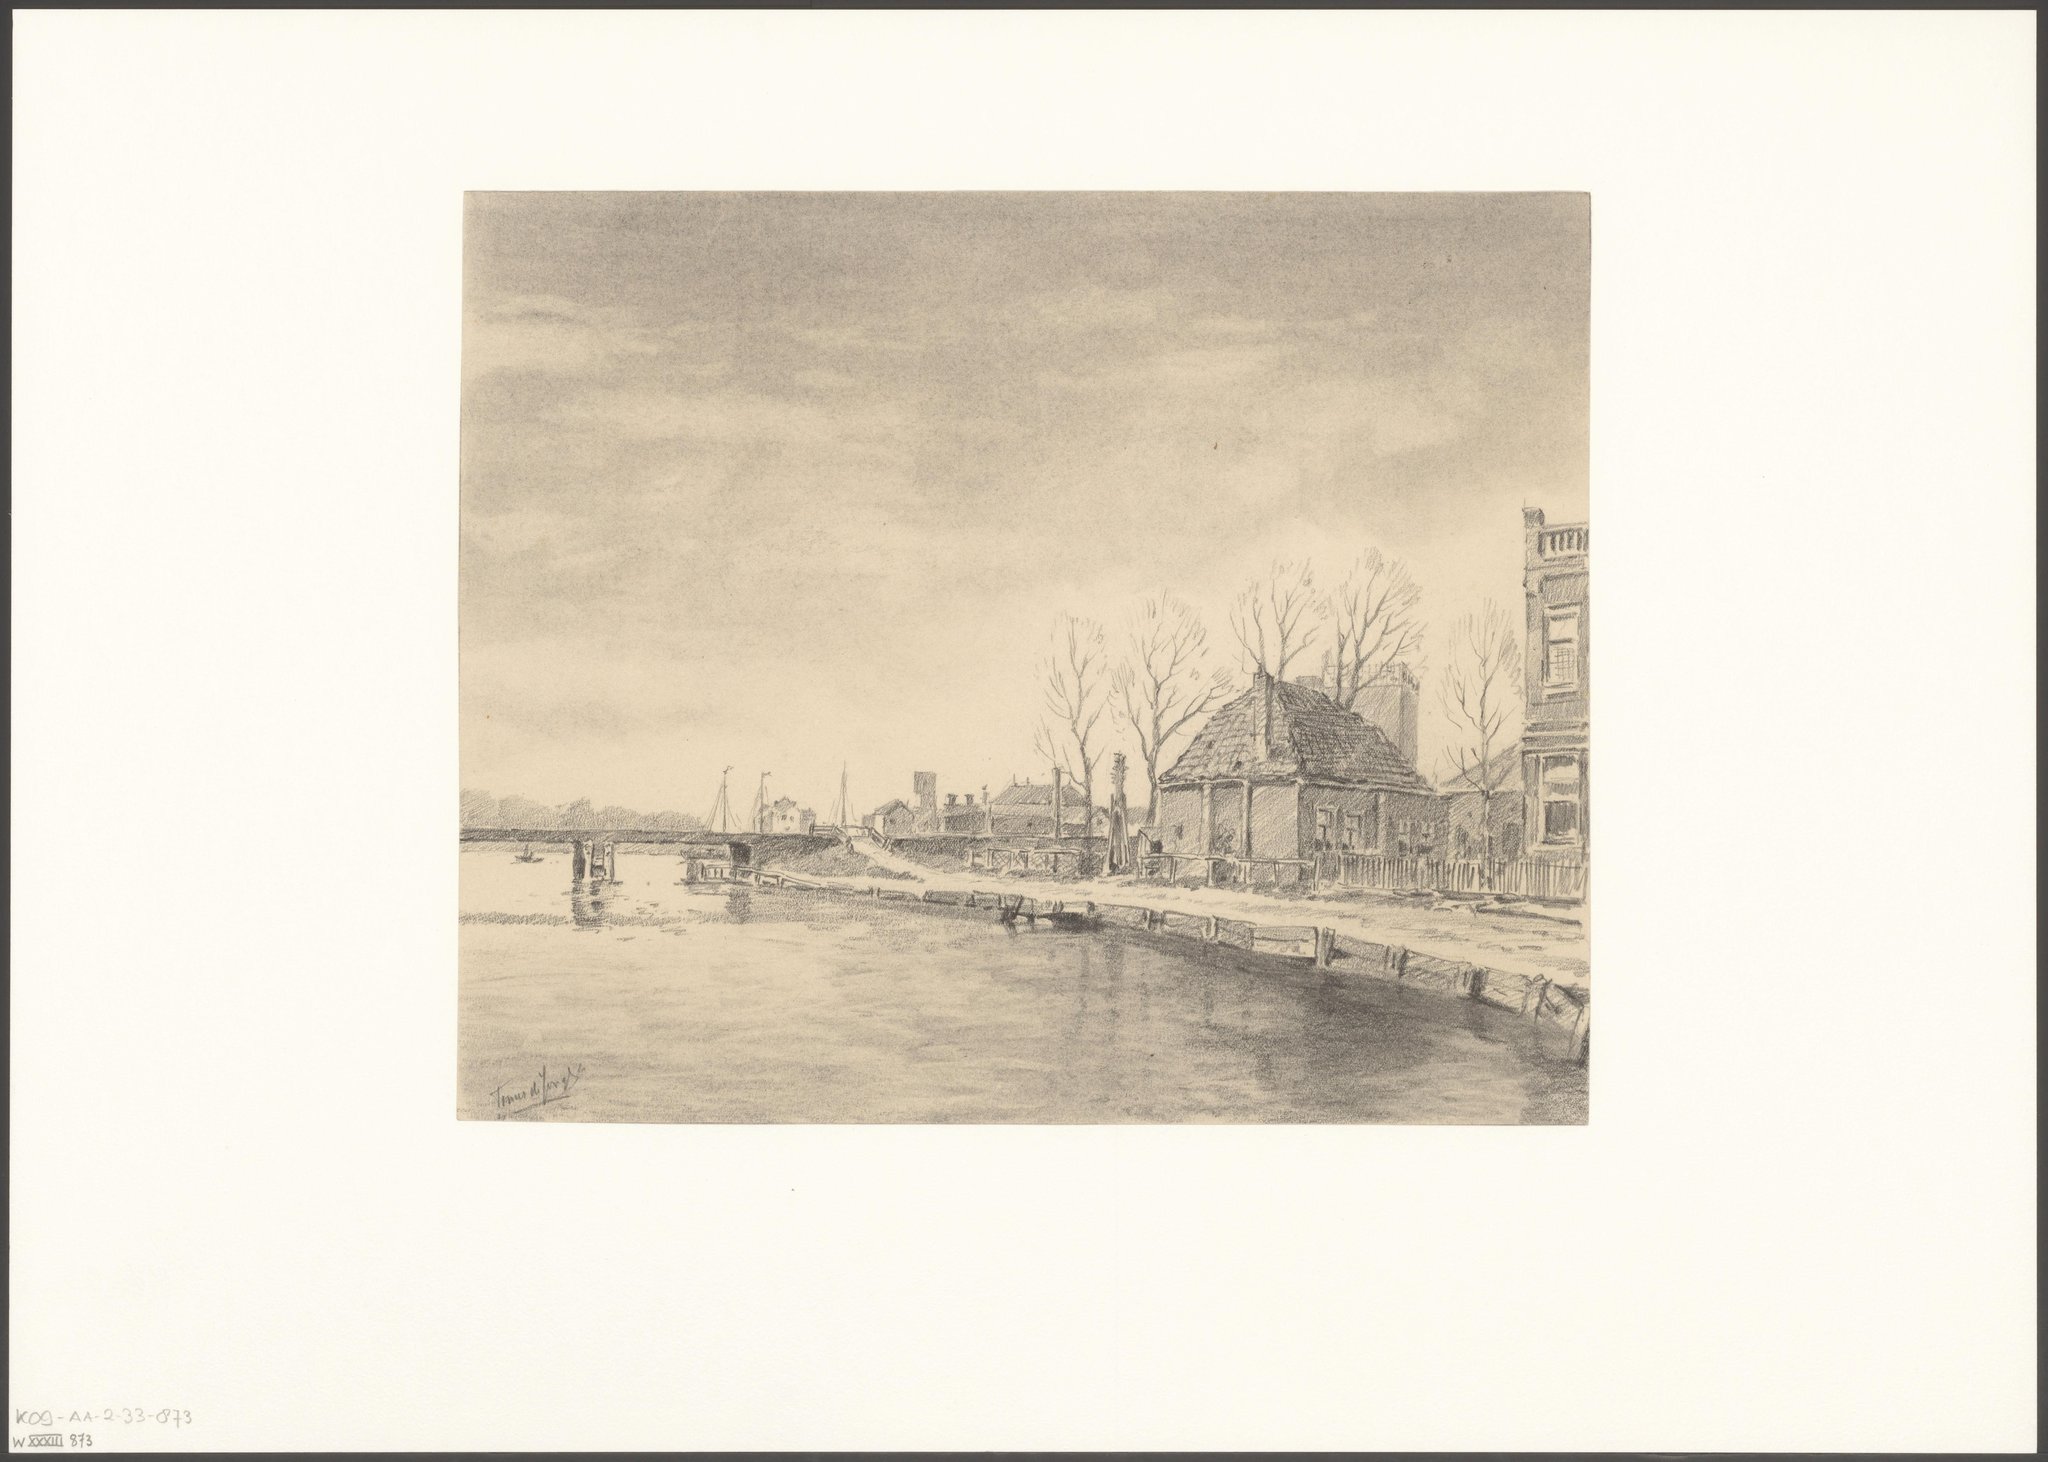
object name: drawing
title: Gezicht op het pad van de Weesperzijde naar de Omval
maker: tinus de jongh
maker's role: print maker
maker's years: 1885-1942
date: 1895-1942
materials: chalk, paper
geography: amsterdam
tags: city-view in general; 'veduta', river, the usual house or row of houses, bridge in city across river, canal, etc.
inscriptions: collector's mark: Lugt 800a, signature: ‘TinusdeJongh’, inscription: ‘pad van Weesperzijde (...) 3. Tinus deJongh’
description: Tekening binnen de Atlas Van Eck ingedeeld op wijknummer 33.